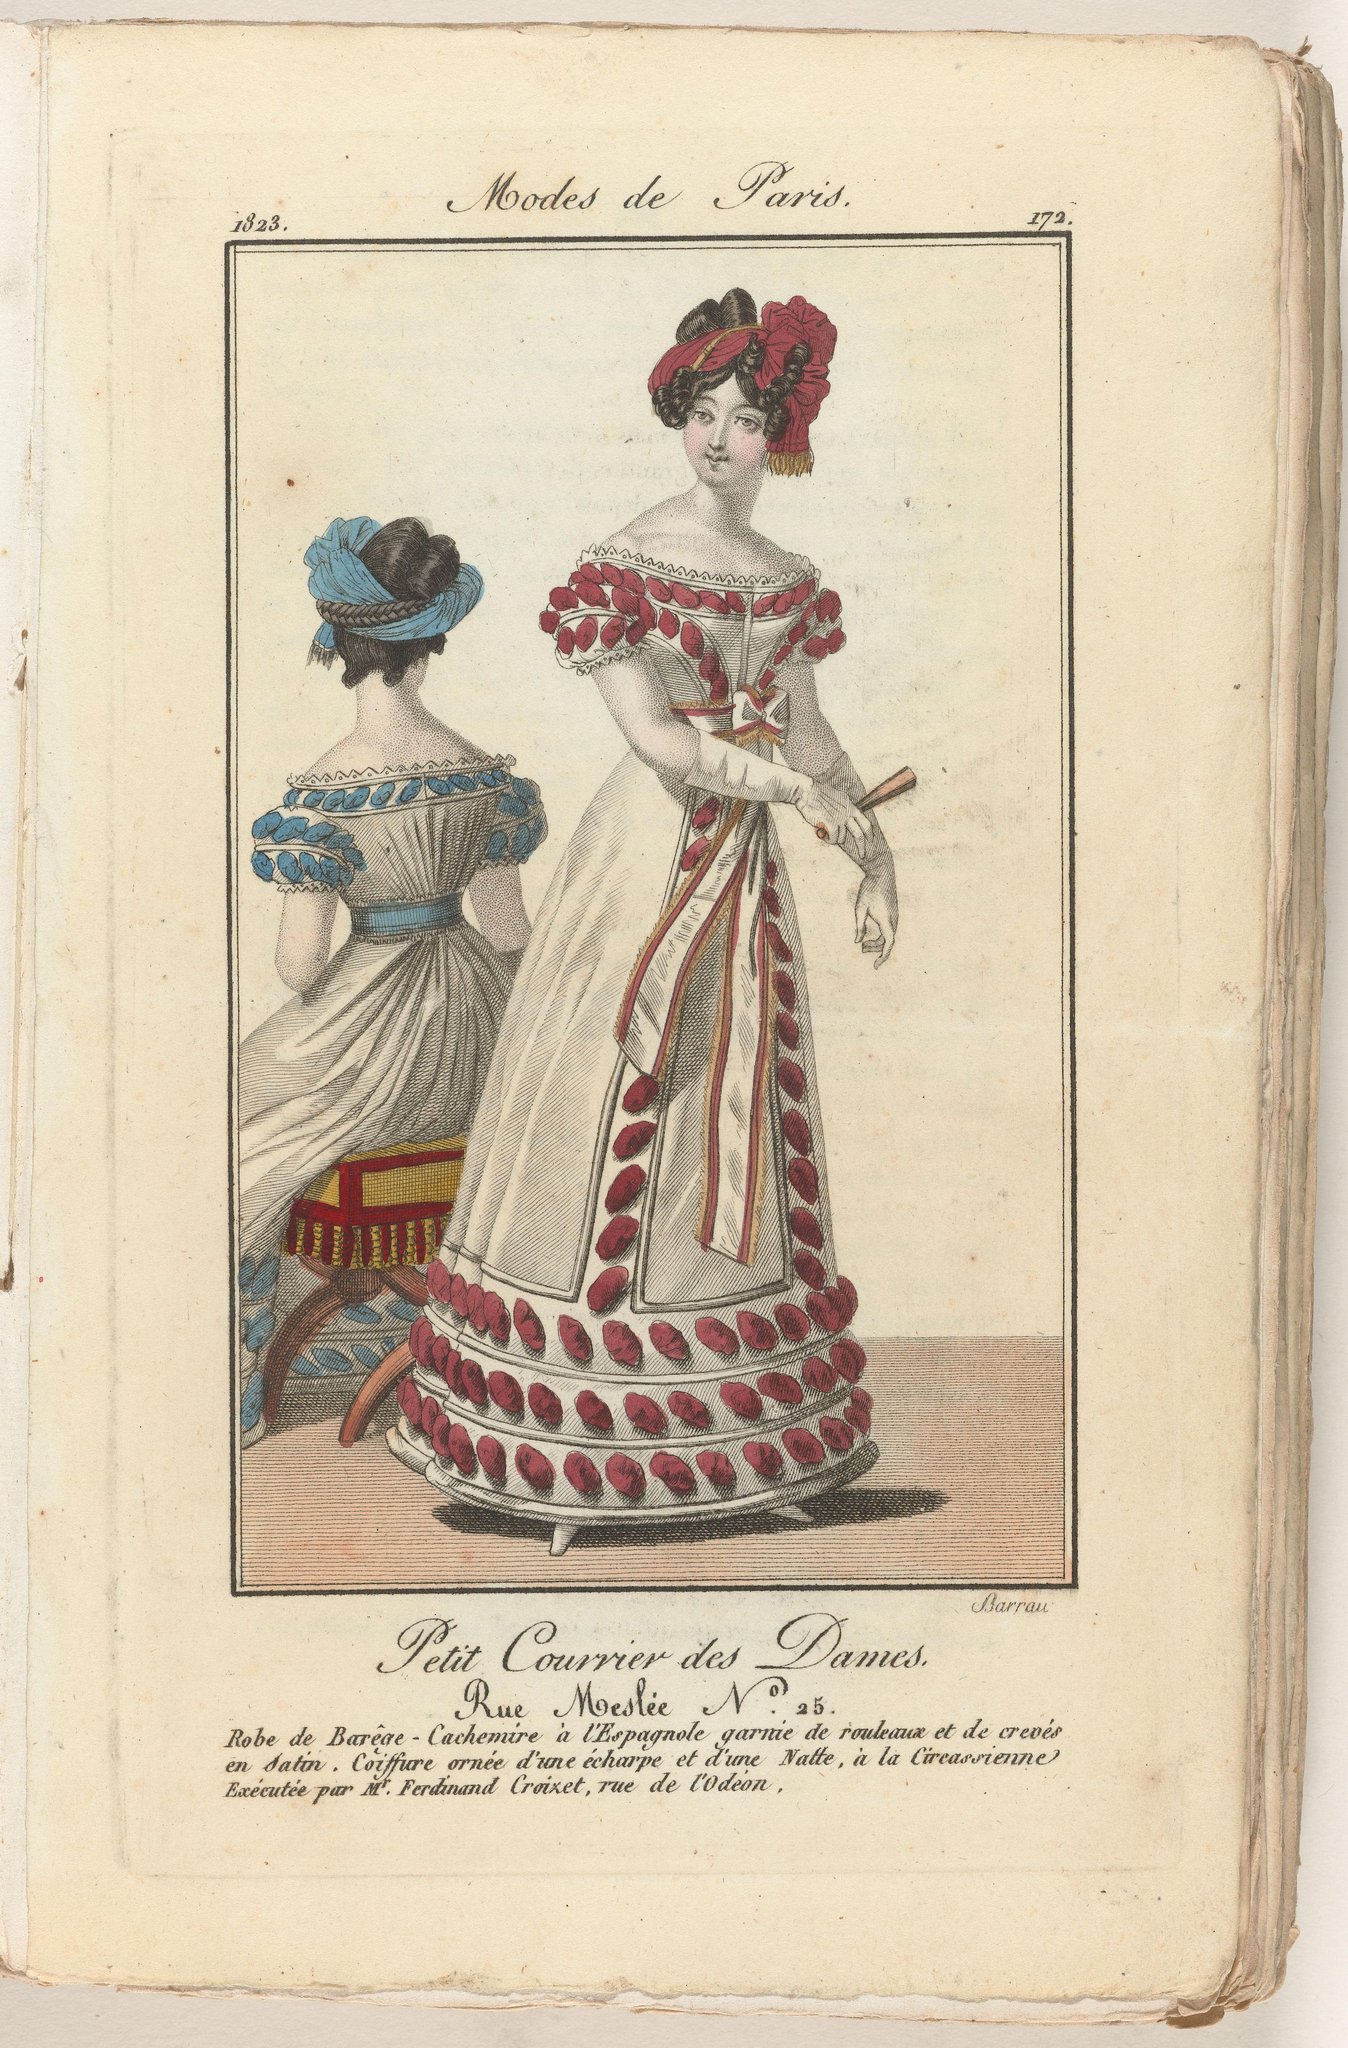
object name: magazine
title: Petit Courrier des Dames 1823 (172)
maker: barrau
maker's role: print maker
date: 1823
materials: paper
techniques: engraving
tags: fashion plates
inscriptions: date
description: Prent uit het modetijdschrift Petit Courrier des Dames (1821-1868).